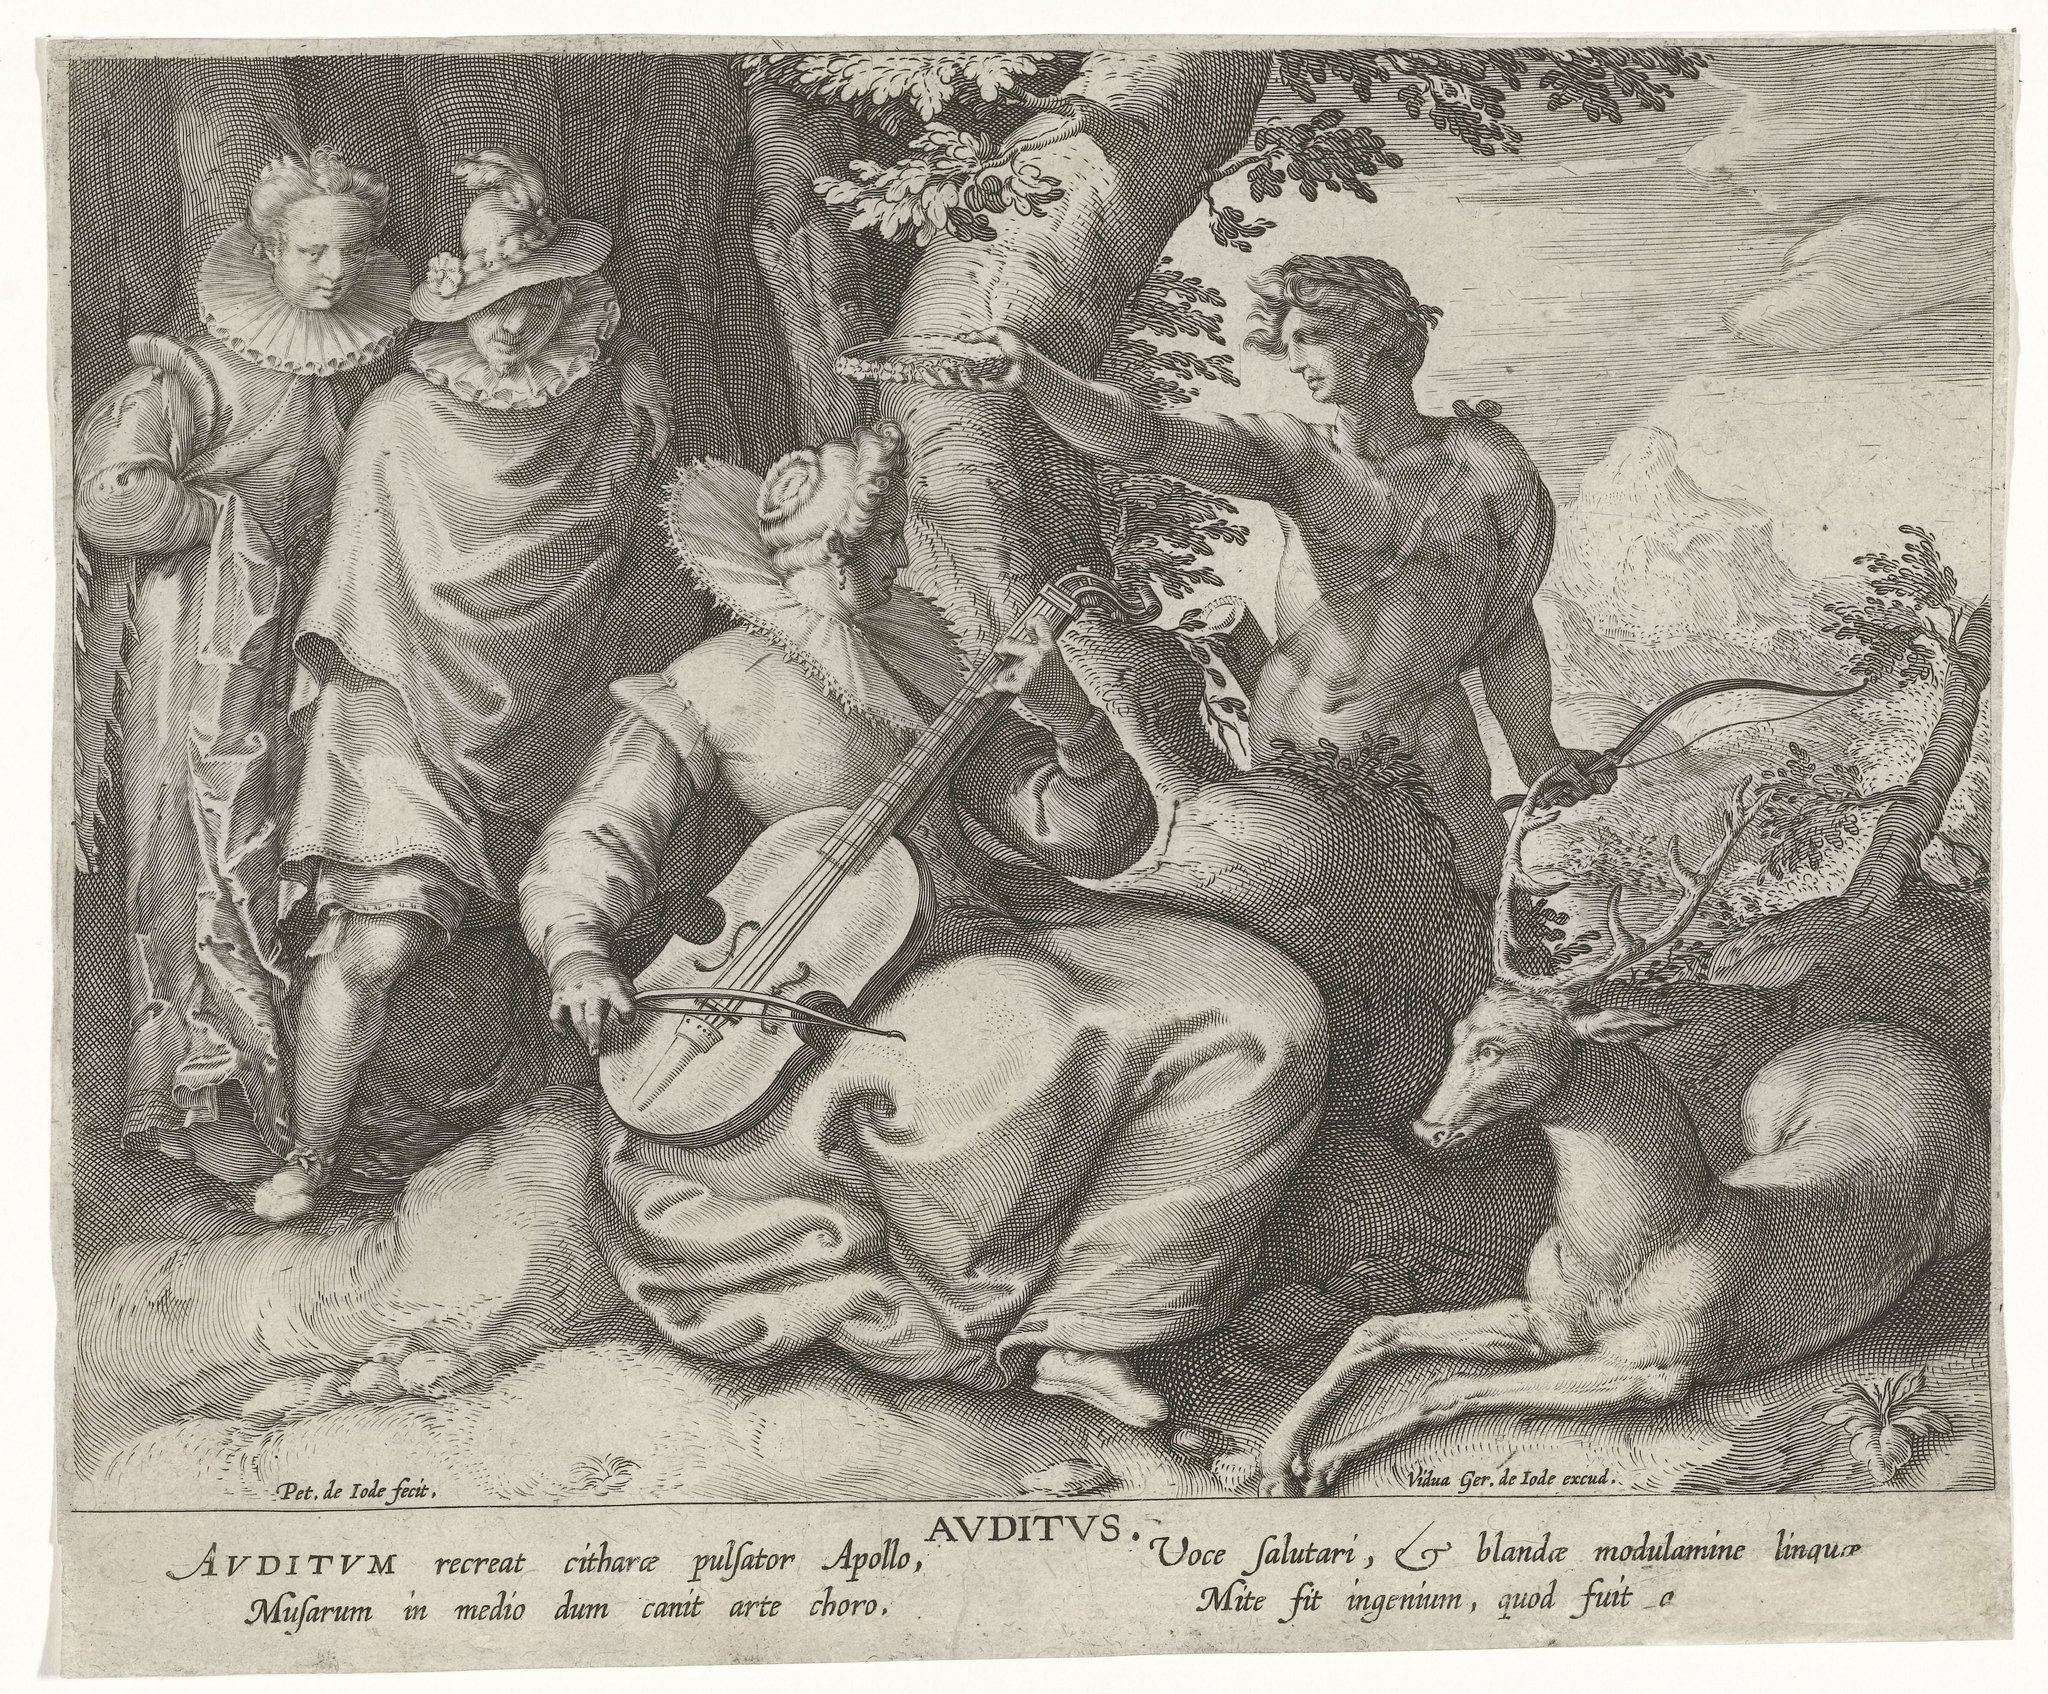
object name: print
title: Avditvs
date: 1590-1632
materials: paper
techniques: engraving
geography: antwerp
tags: hearing, listening (one of the five senses), (story of) apollo (phoebus)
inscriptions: collector's mark: Lugt 2228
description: Landschap met de vrouwelijke personificatie van het Gehoor, die een vedel bespeelt. Ze wordt vergezeld door een hert en gekroond door Apollo. Linksachter staat een paar dat toekijkt. In de marge, in twee kolommen, een onderschrift in het Latijn. Prent uit een serie van vijf met de vijf zintuigen.